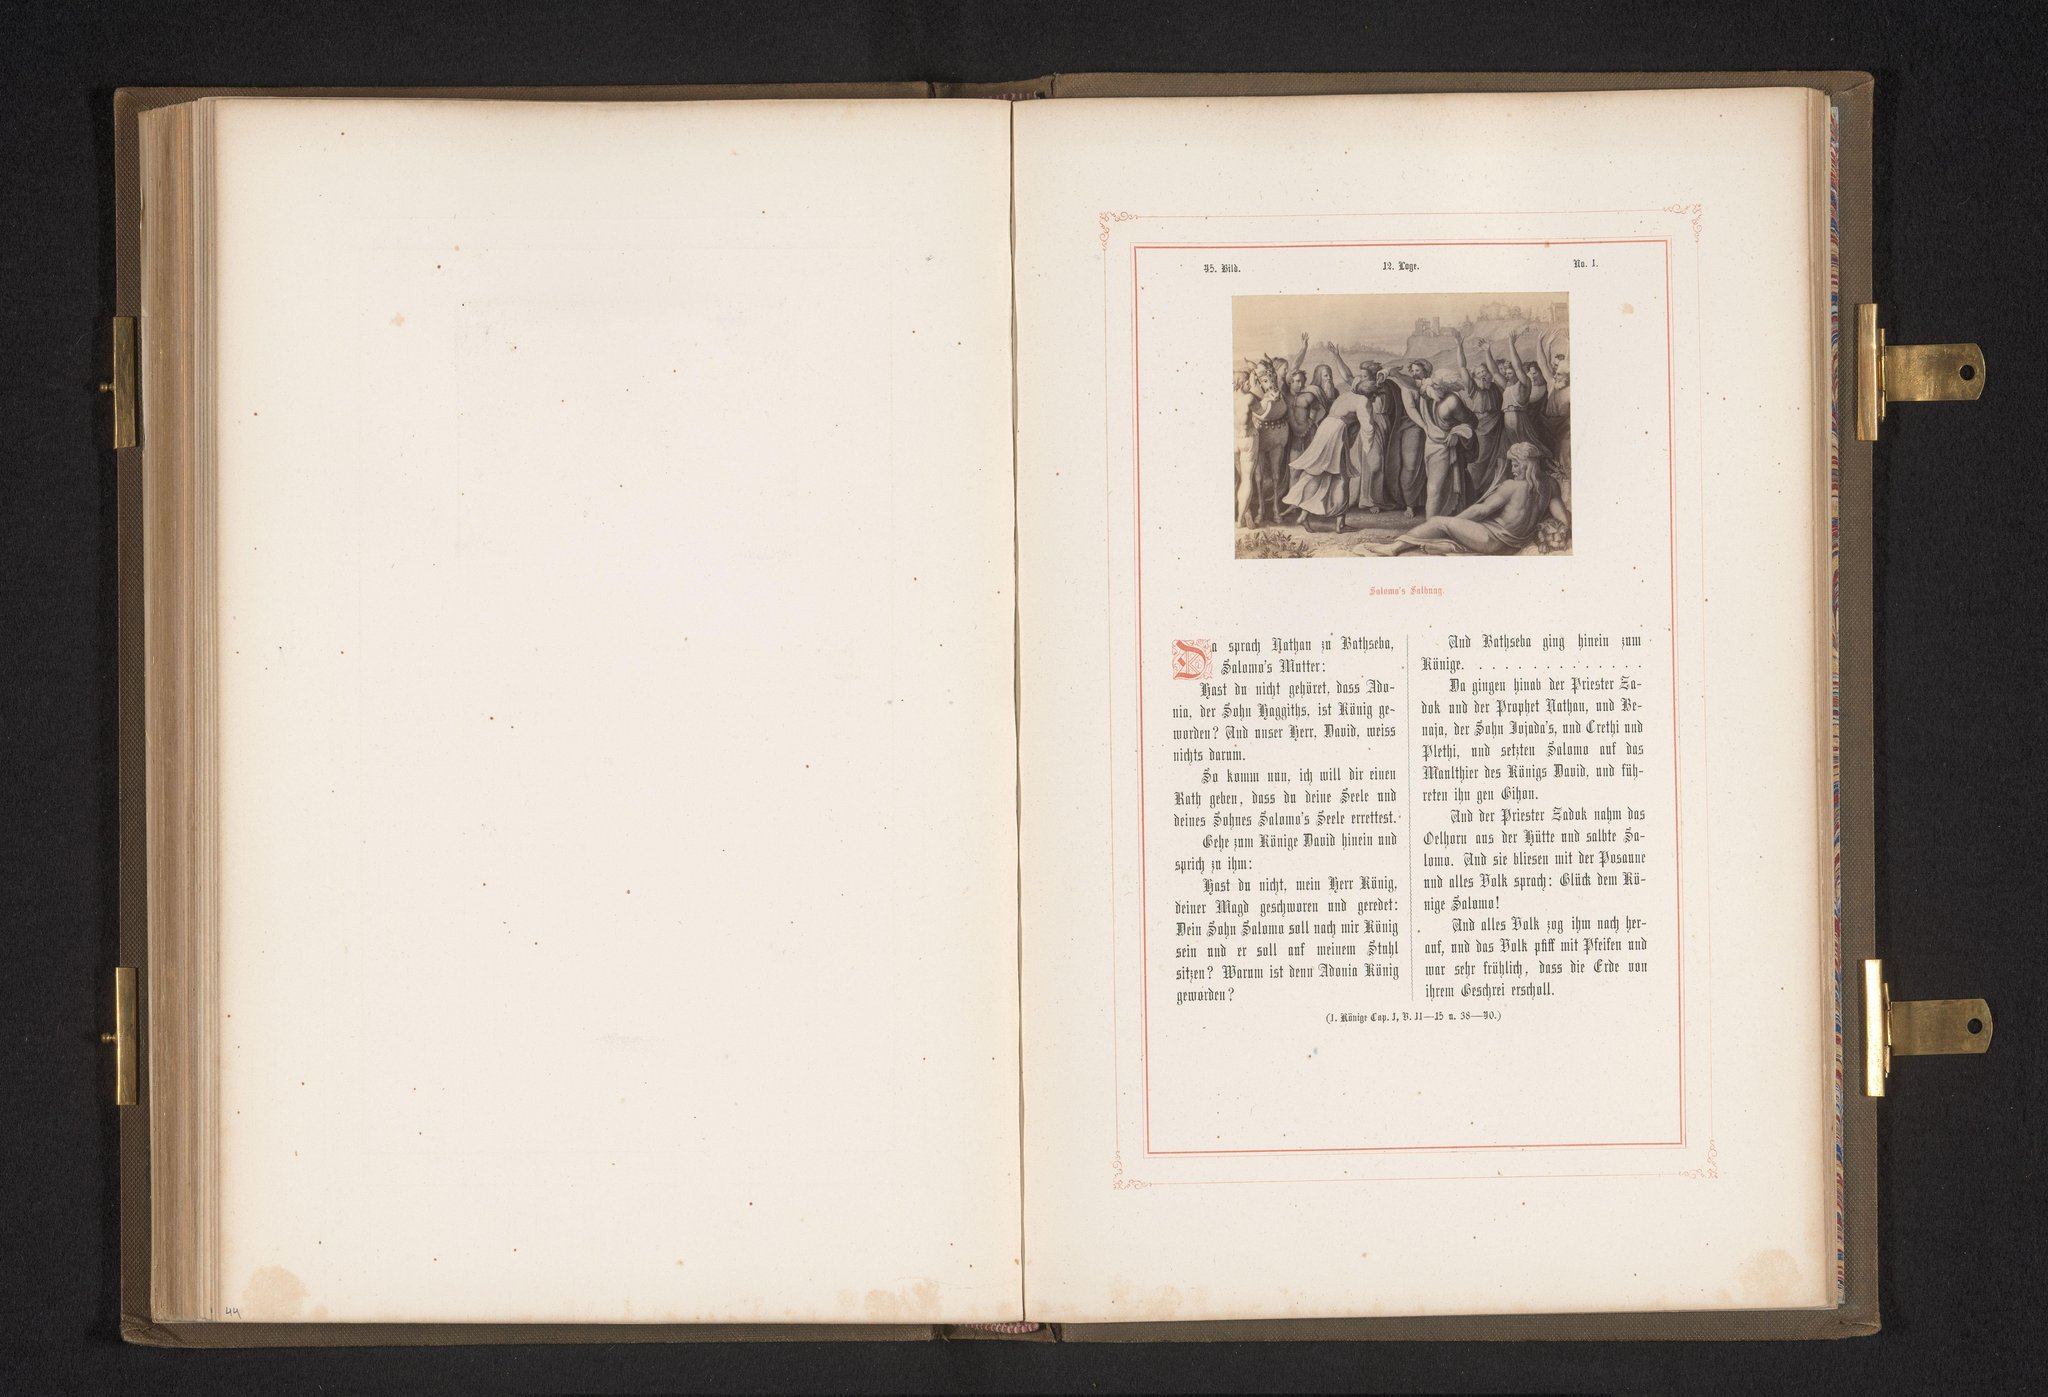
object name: page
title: Salomo's Salbung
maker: gustav schauer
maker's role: painter, publisher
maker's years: 1826-1902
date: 1851-1861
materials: photographic support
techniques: albumen print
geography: berlin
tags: solomon anointed king by zadok; all the people rejoice and blow their trumpets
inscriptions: inscription: ‘45. Bild. 12. Loge. No. 1.’